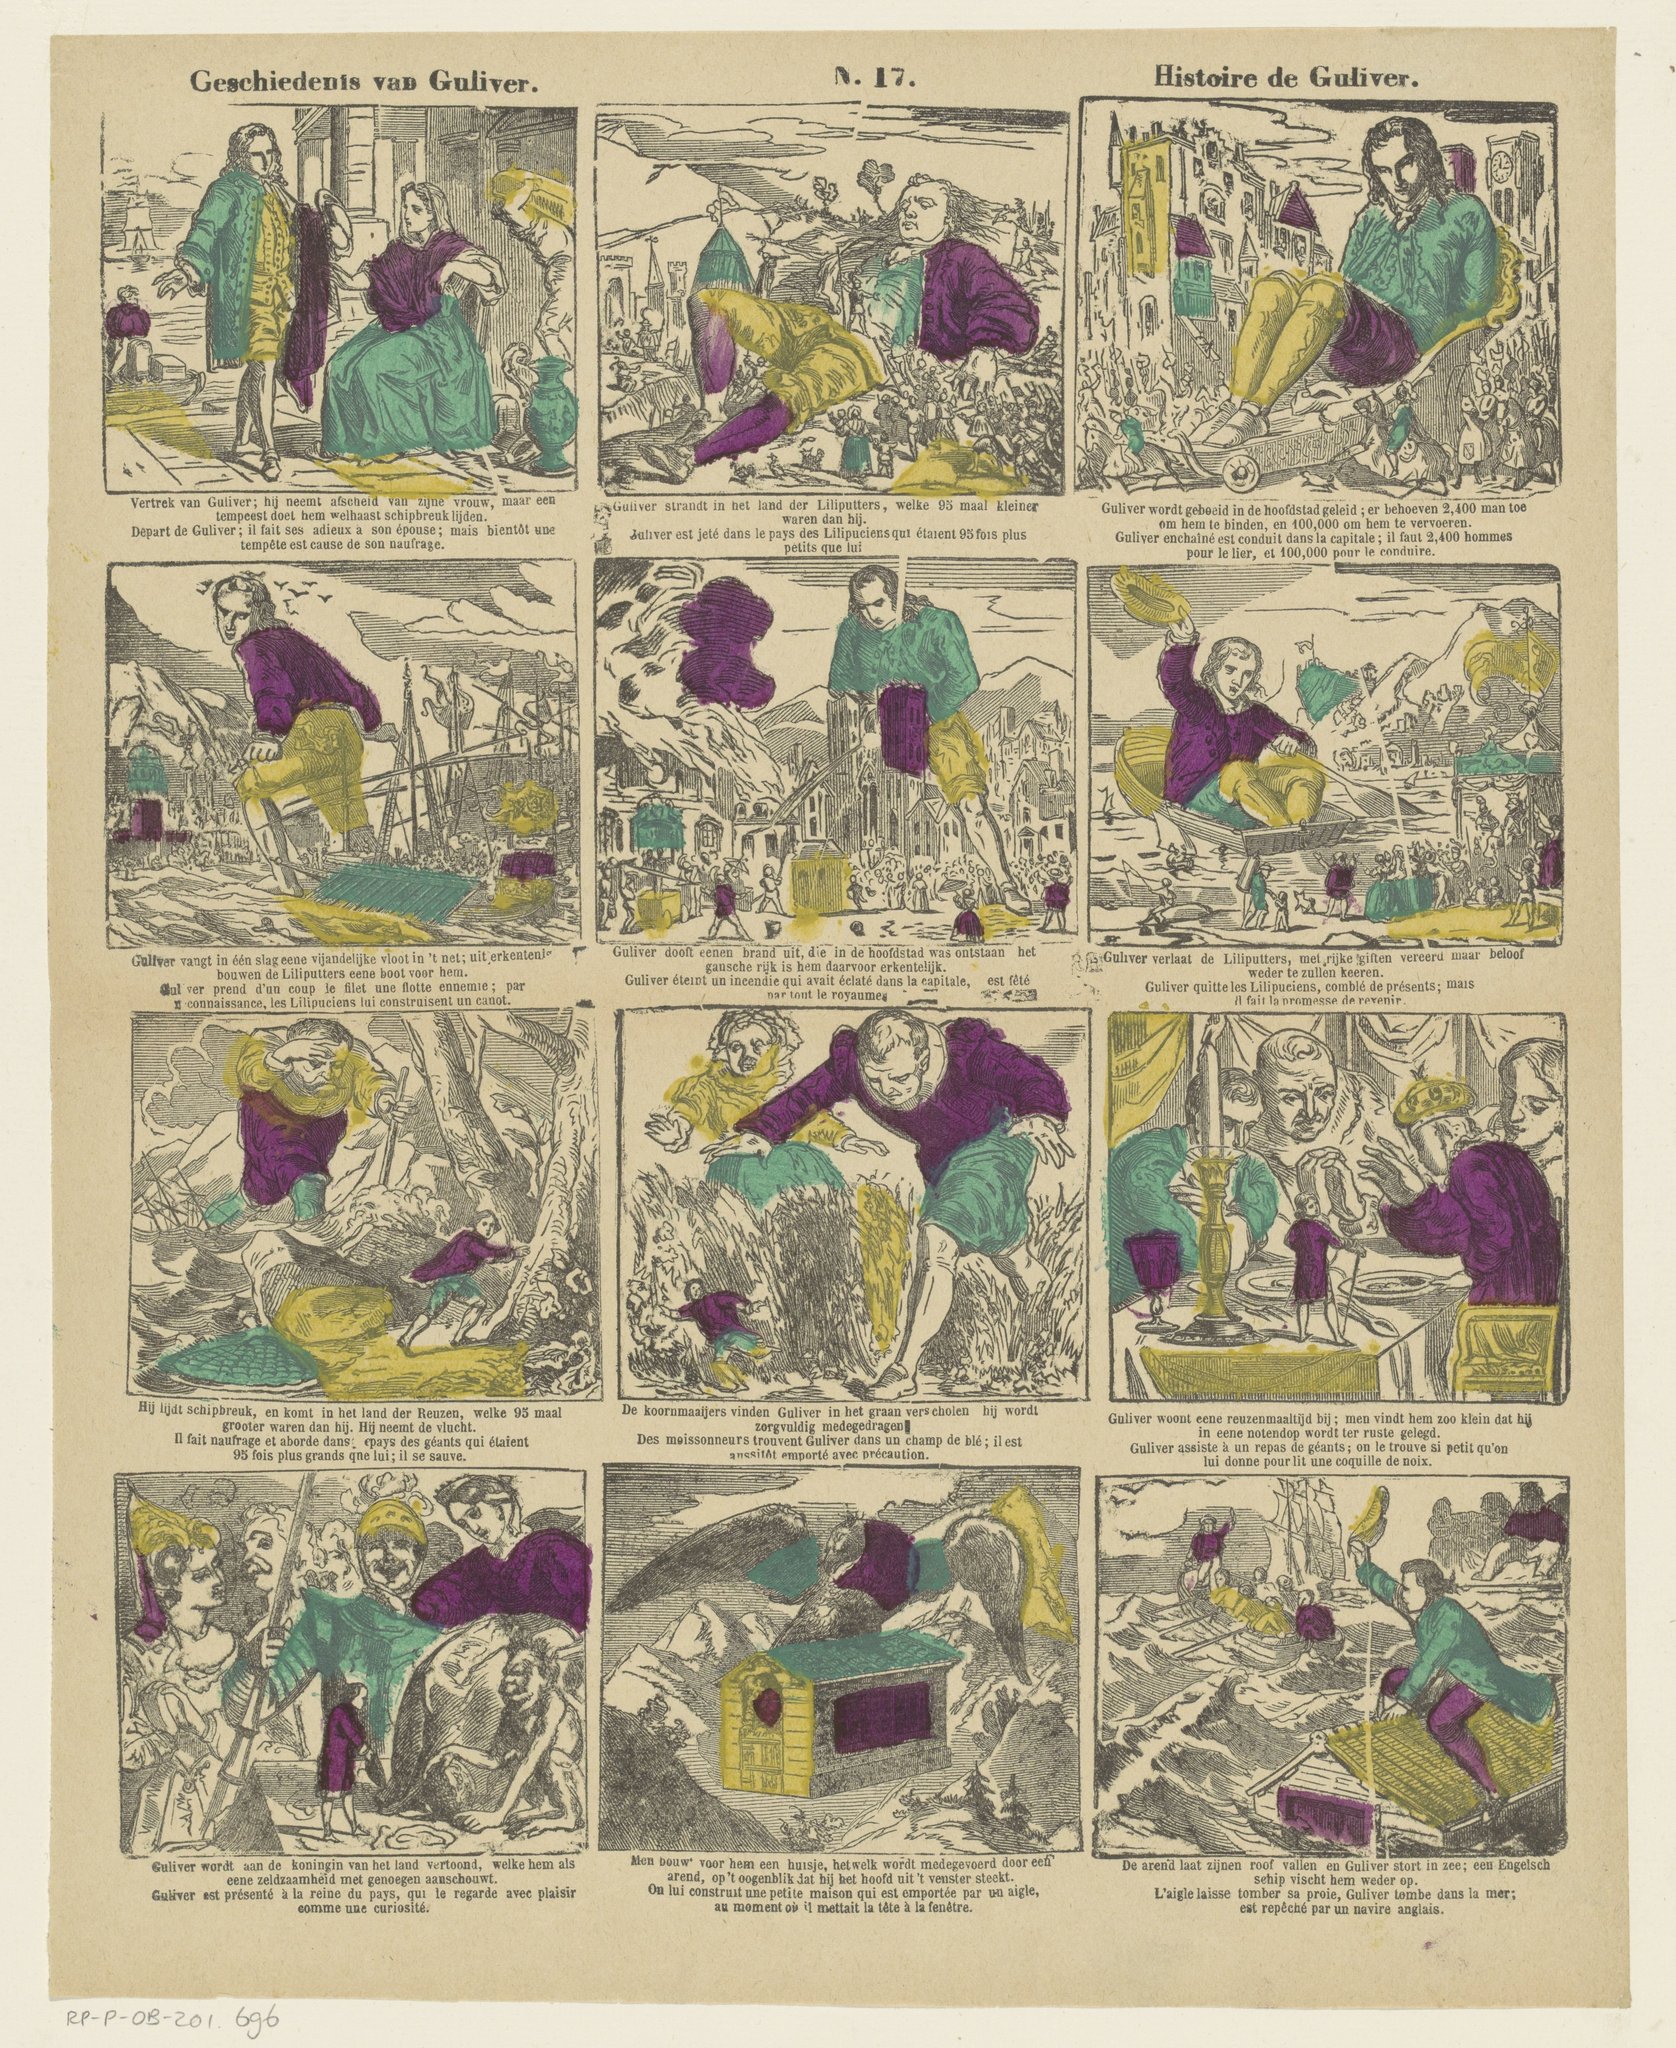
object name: popular print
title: Geschiedenis van Guliver / Histoire de Guliver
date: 1800-1833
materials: paper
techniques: colour, letterpress printing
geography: turnhout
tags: (scenes from) specific works of literature: swift, gulliver's travels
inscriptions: collector's mark: Lugt 2760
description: Blad met 12 voorstellingen uit Gullivers reizen, waaronder Gulliver in Lilliput en twee reuzen die Gulliver gevangennemen. Onder elke voorstelling een tweeregelig vers in het Nederlands en het Frans. Genummerd midden boven: N. 17.